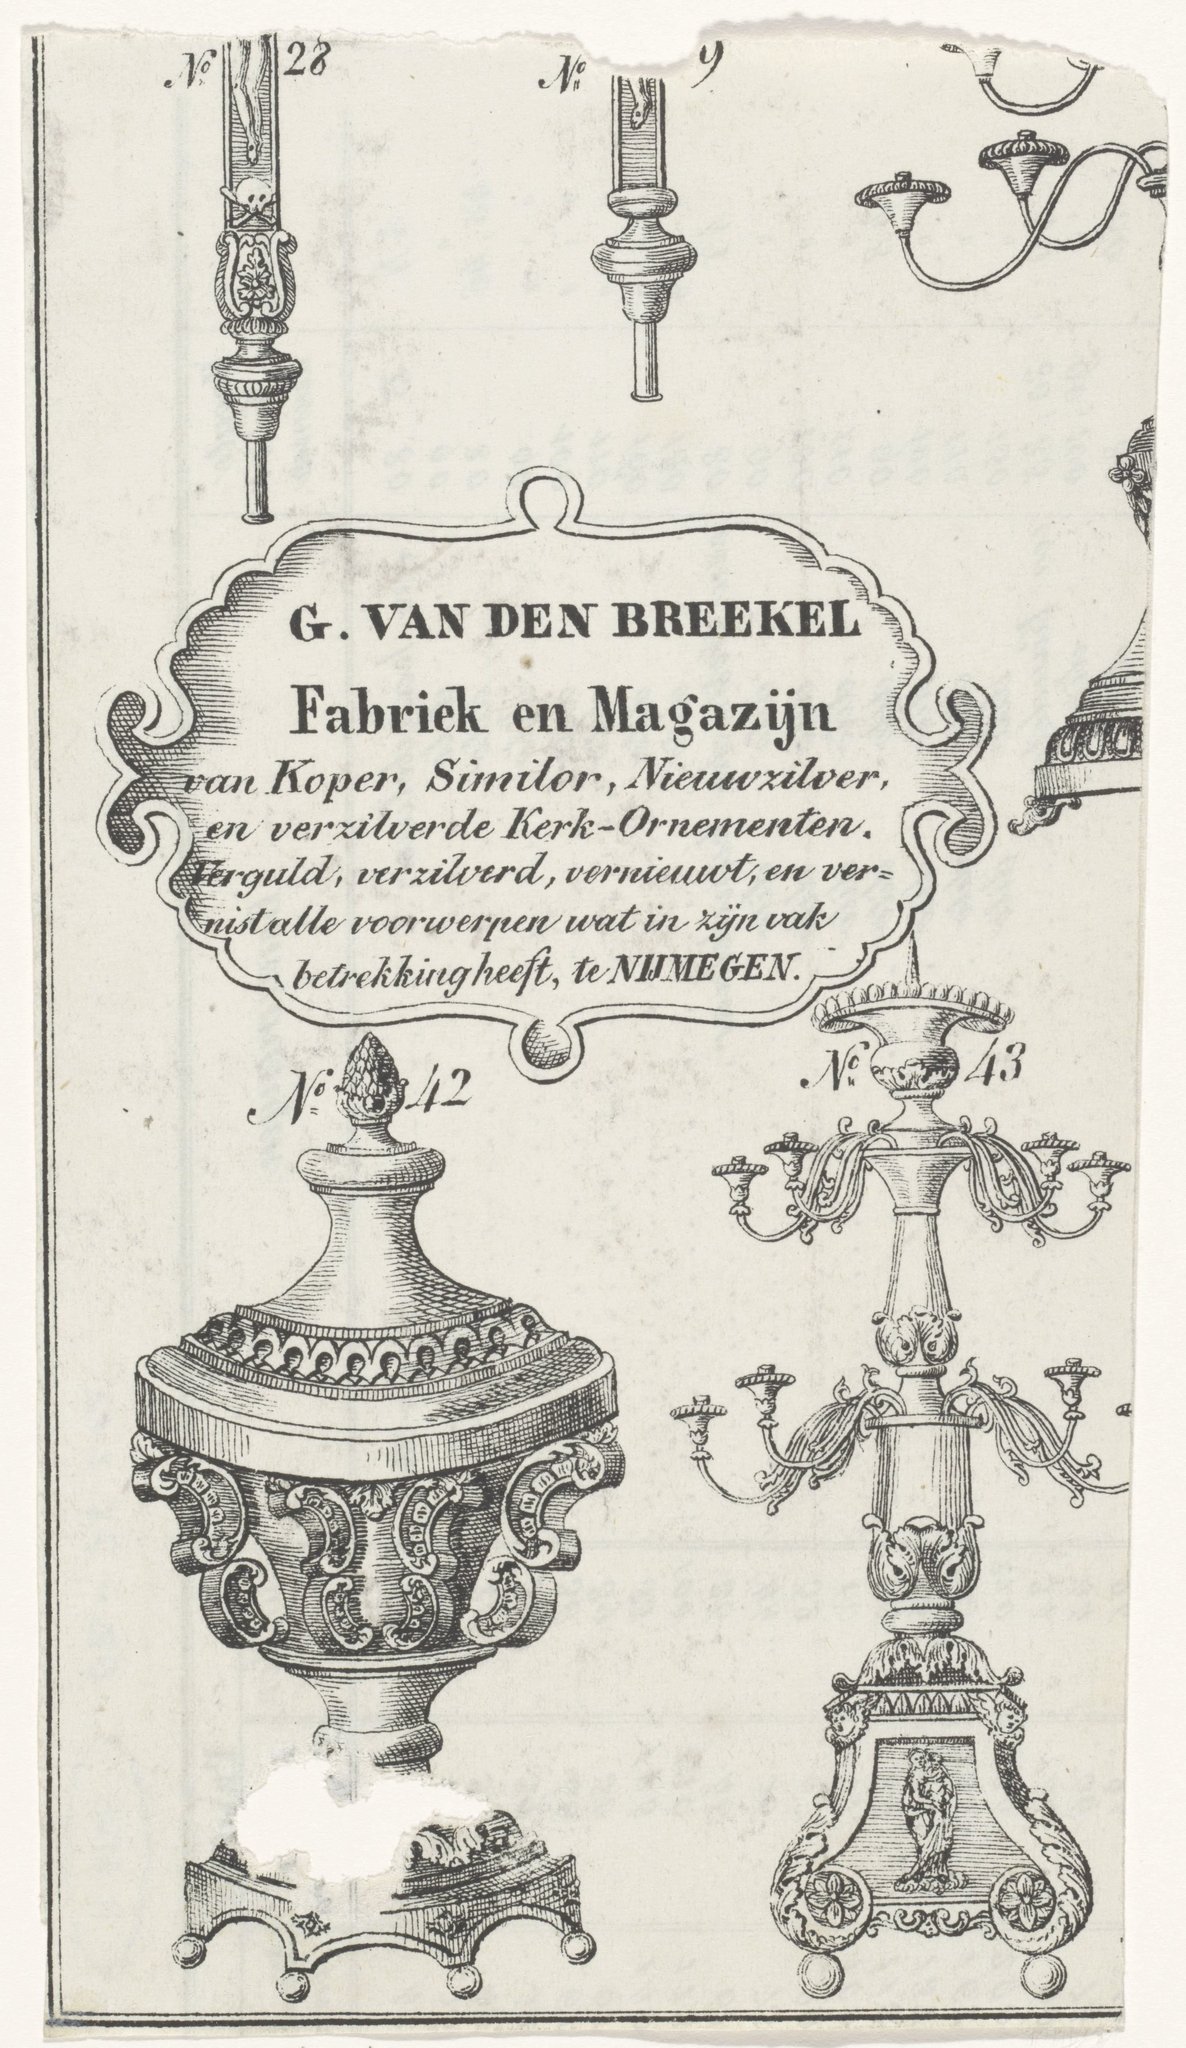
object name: ornament print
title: Kerkornamenten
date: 1890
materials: paper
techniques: engraving, etching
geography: nijmegen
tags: (liturgical) equipment of church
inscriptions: collector's mark: Lugt 2228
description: Enkele kerkornamenten. Fragment van een bladzijde uit een catalogus van G. van den Breekel, fabriek en magazijn van kerkornamenten te Nijmegen. Op het verso een lijst met nummers en prijzen.